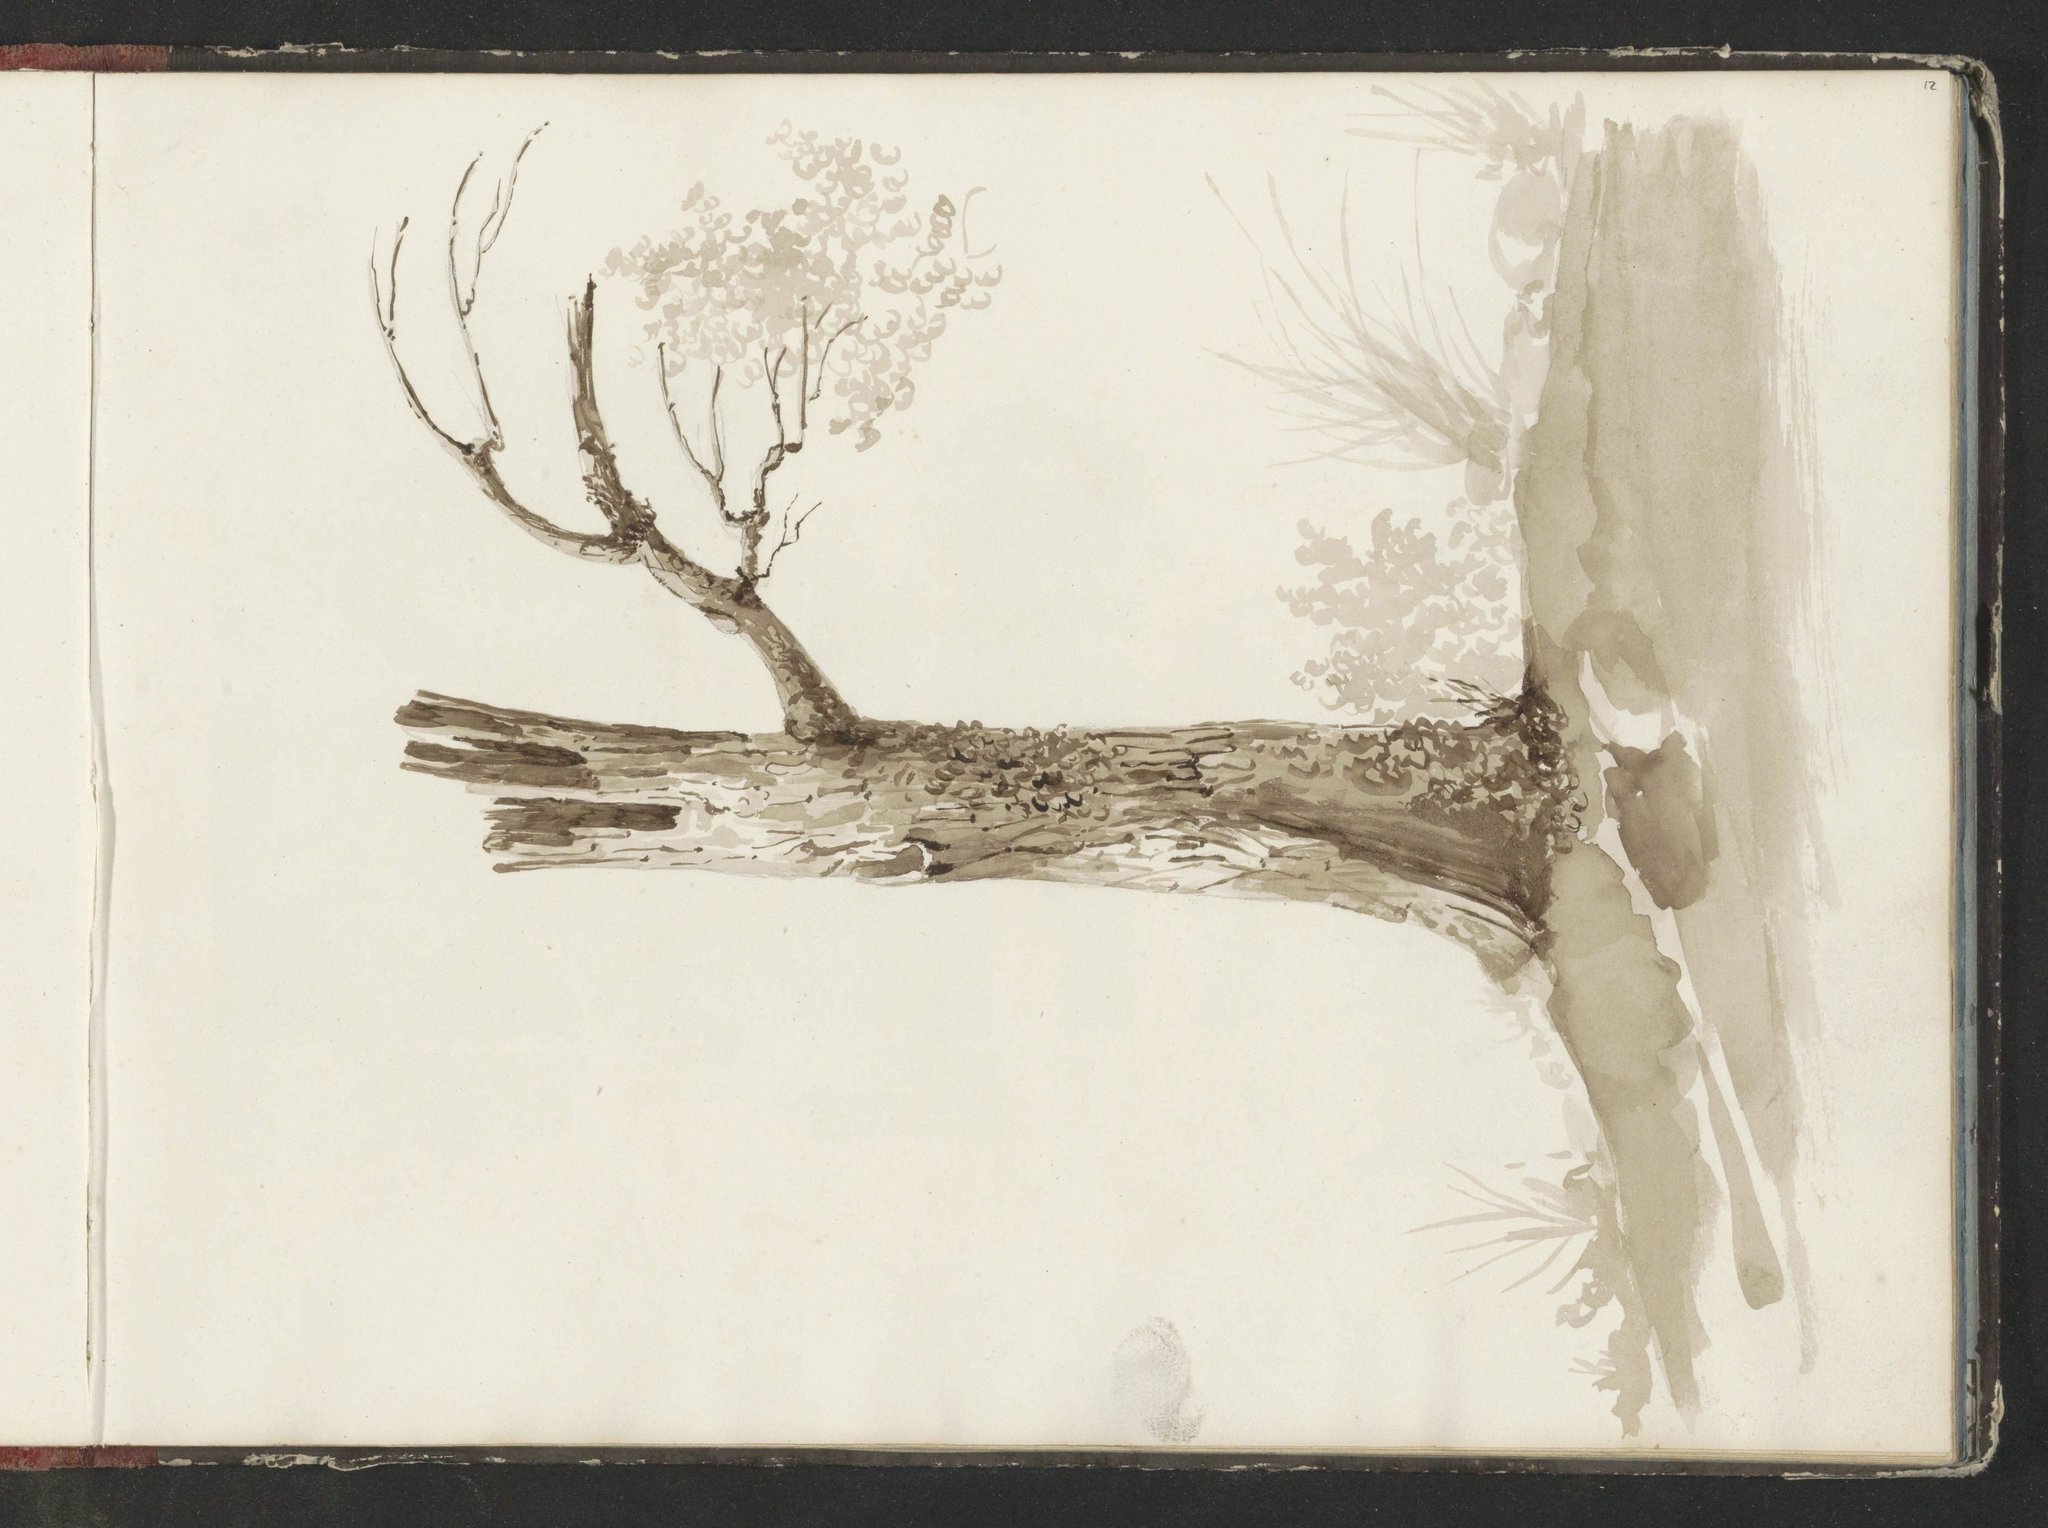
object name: sketchbook leaf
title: Gehalveerde boomstam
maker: Anonymous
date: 1819-1870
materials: ink, paper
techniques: brush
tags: trees (+ stem, trunk)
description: Boomstam met één zijtak, vermoedelijk door weersomstandigheden gehalveerd. Blad 12 recto uit een schetsboek met 39 bladen.